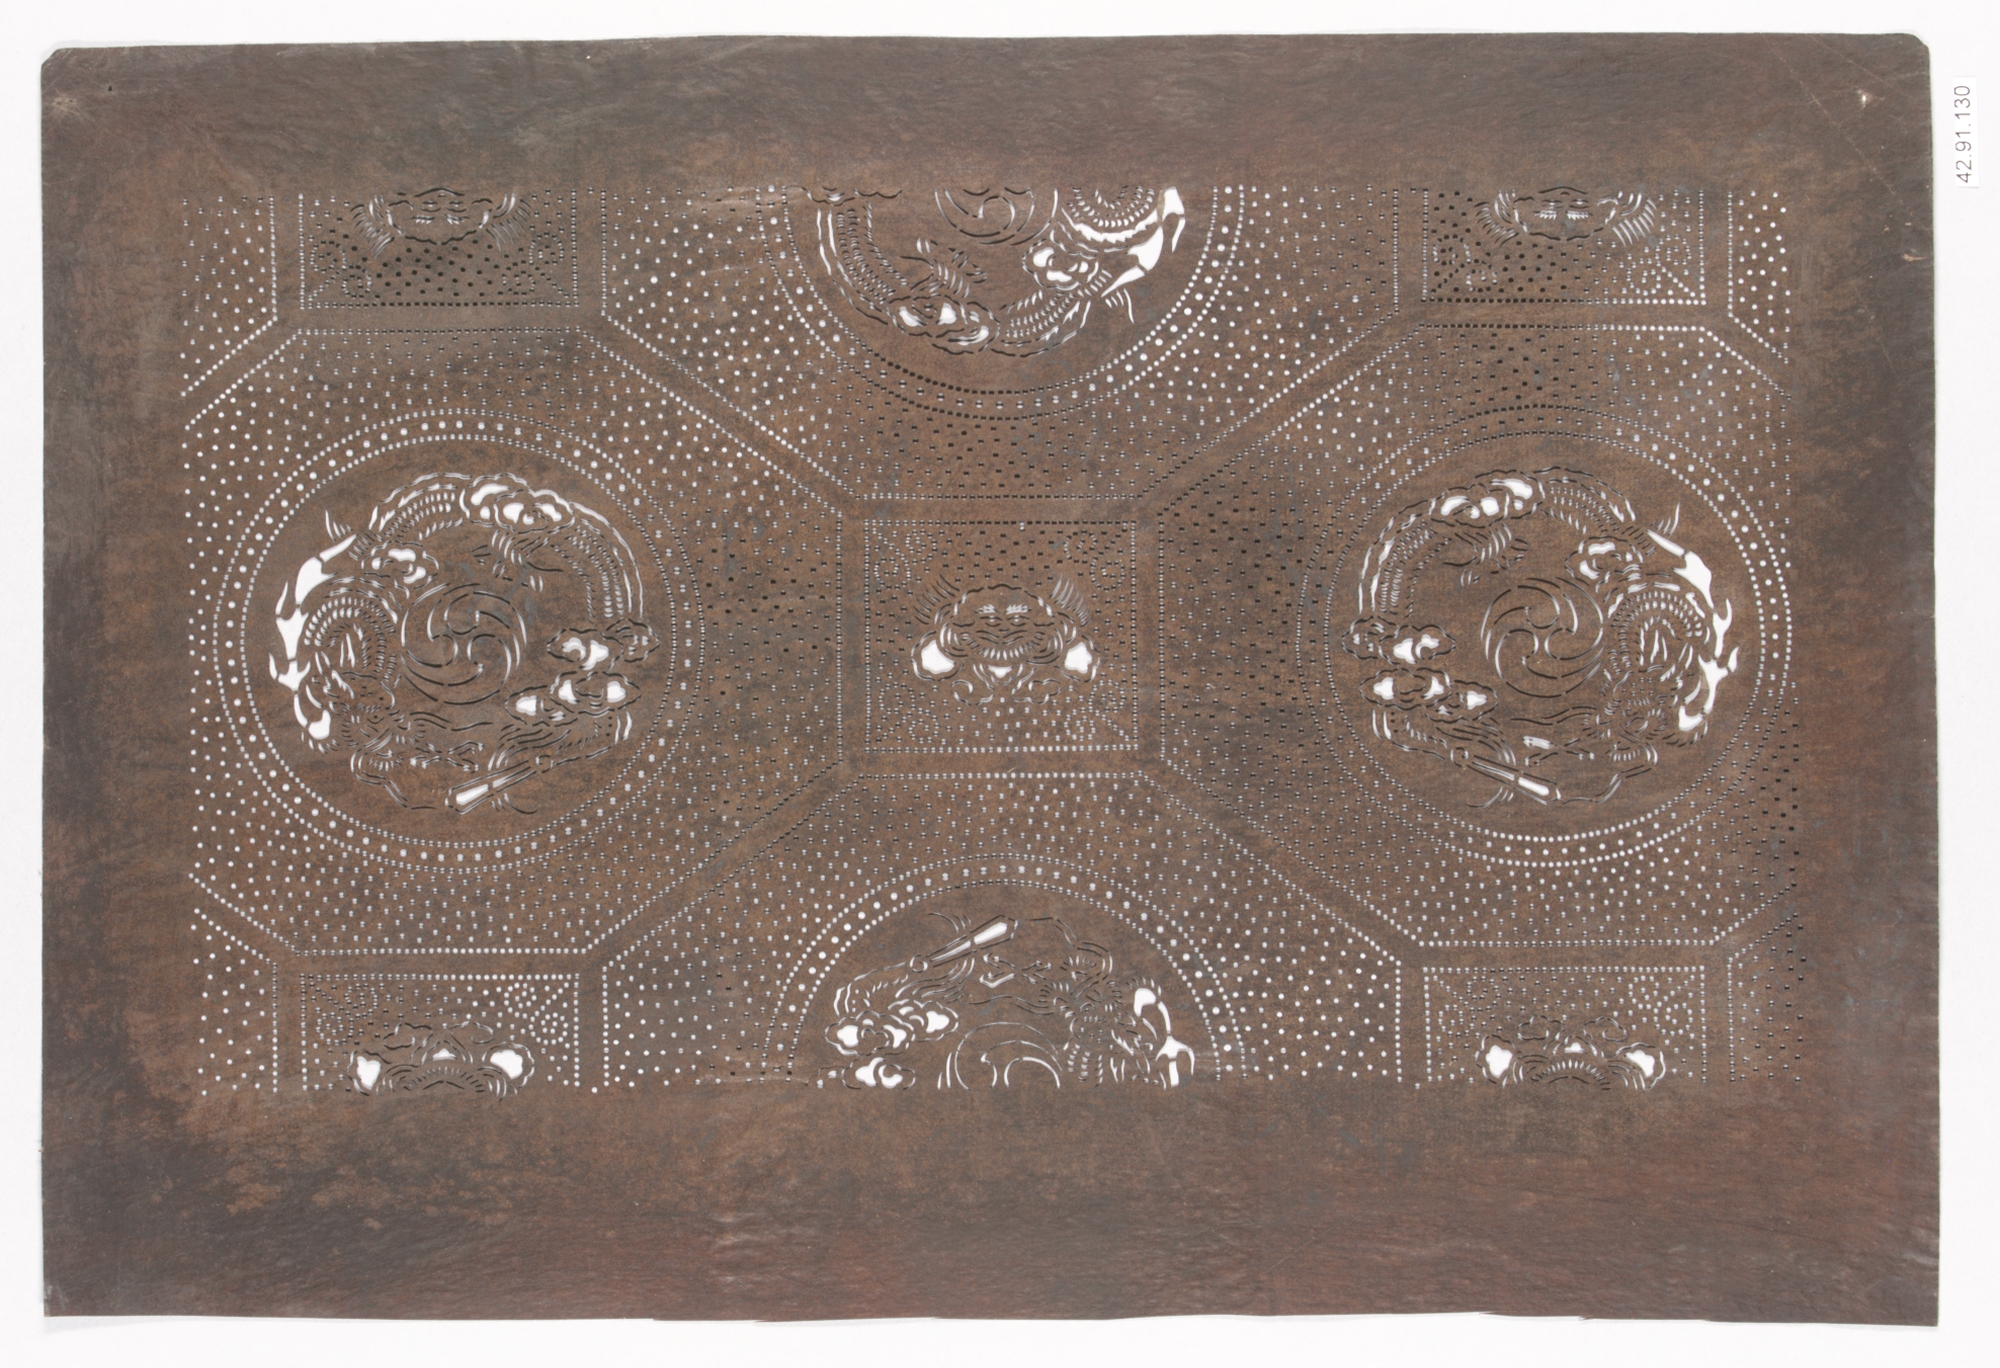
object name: stencil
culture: japanese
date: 1801-1900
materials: paper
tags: dragons